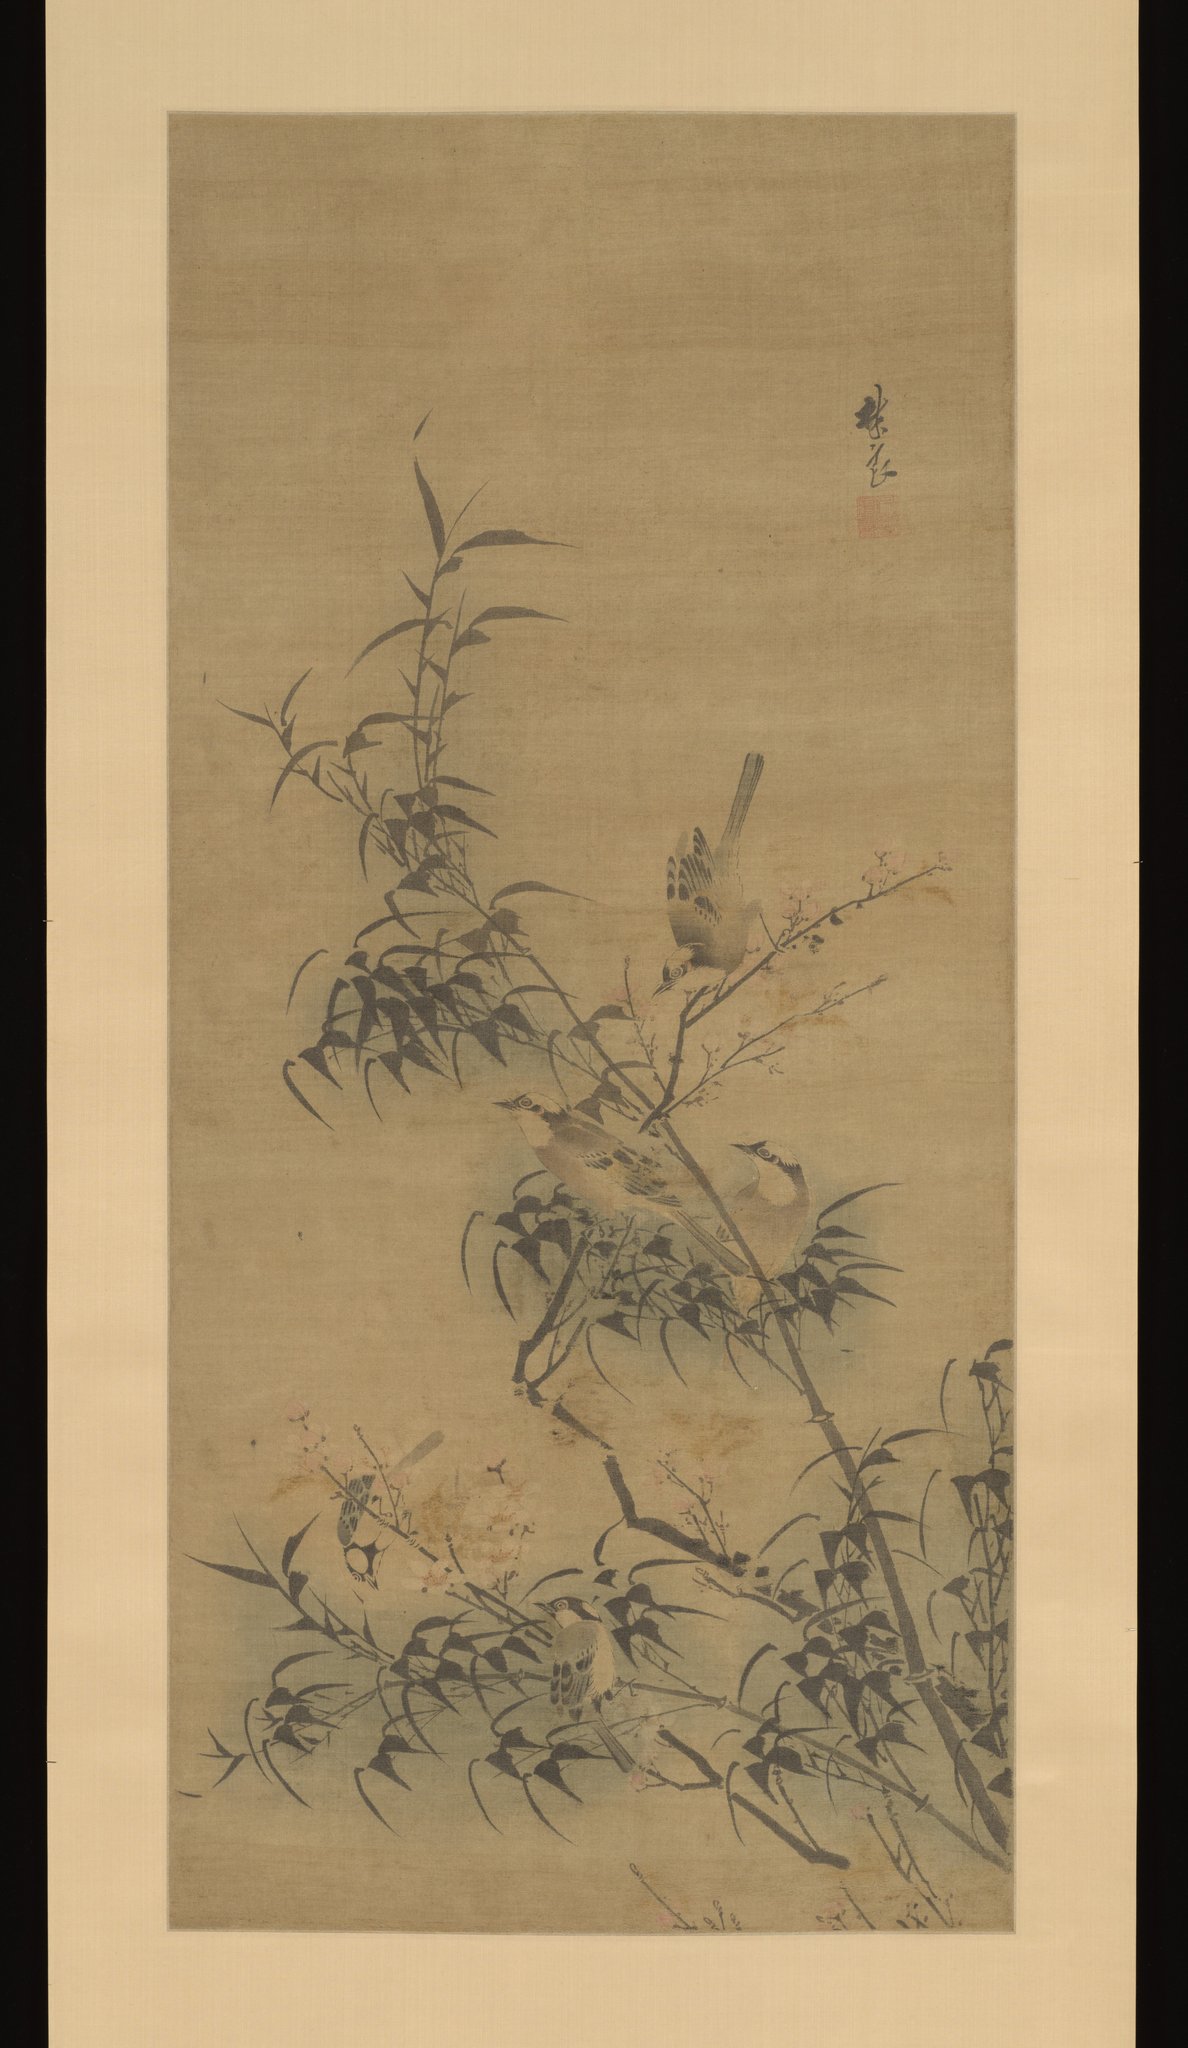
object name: hanging scroll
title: Birds Amidst Blossoming Plum and Bamboo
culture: chinese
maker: lin liang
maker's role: artist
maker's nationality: chinese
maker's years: 1416-1480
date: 1416-1480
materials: ink, silk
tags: birds,bamboo